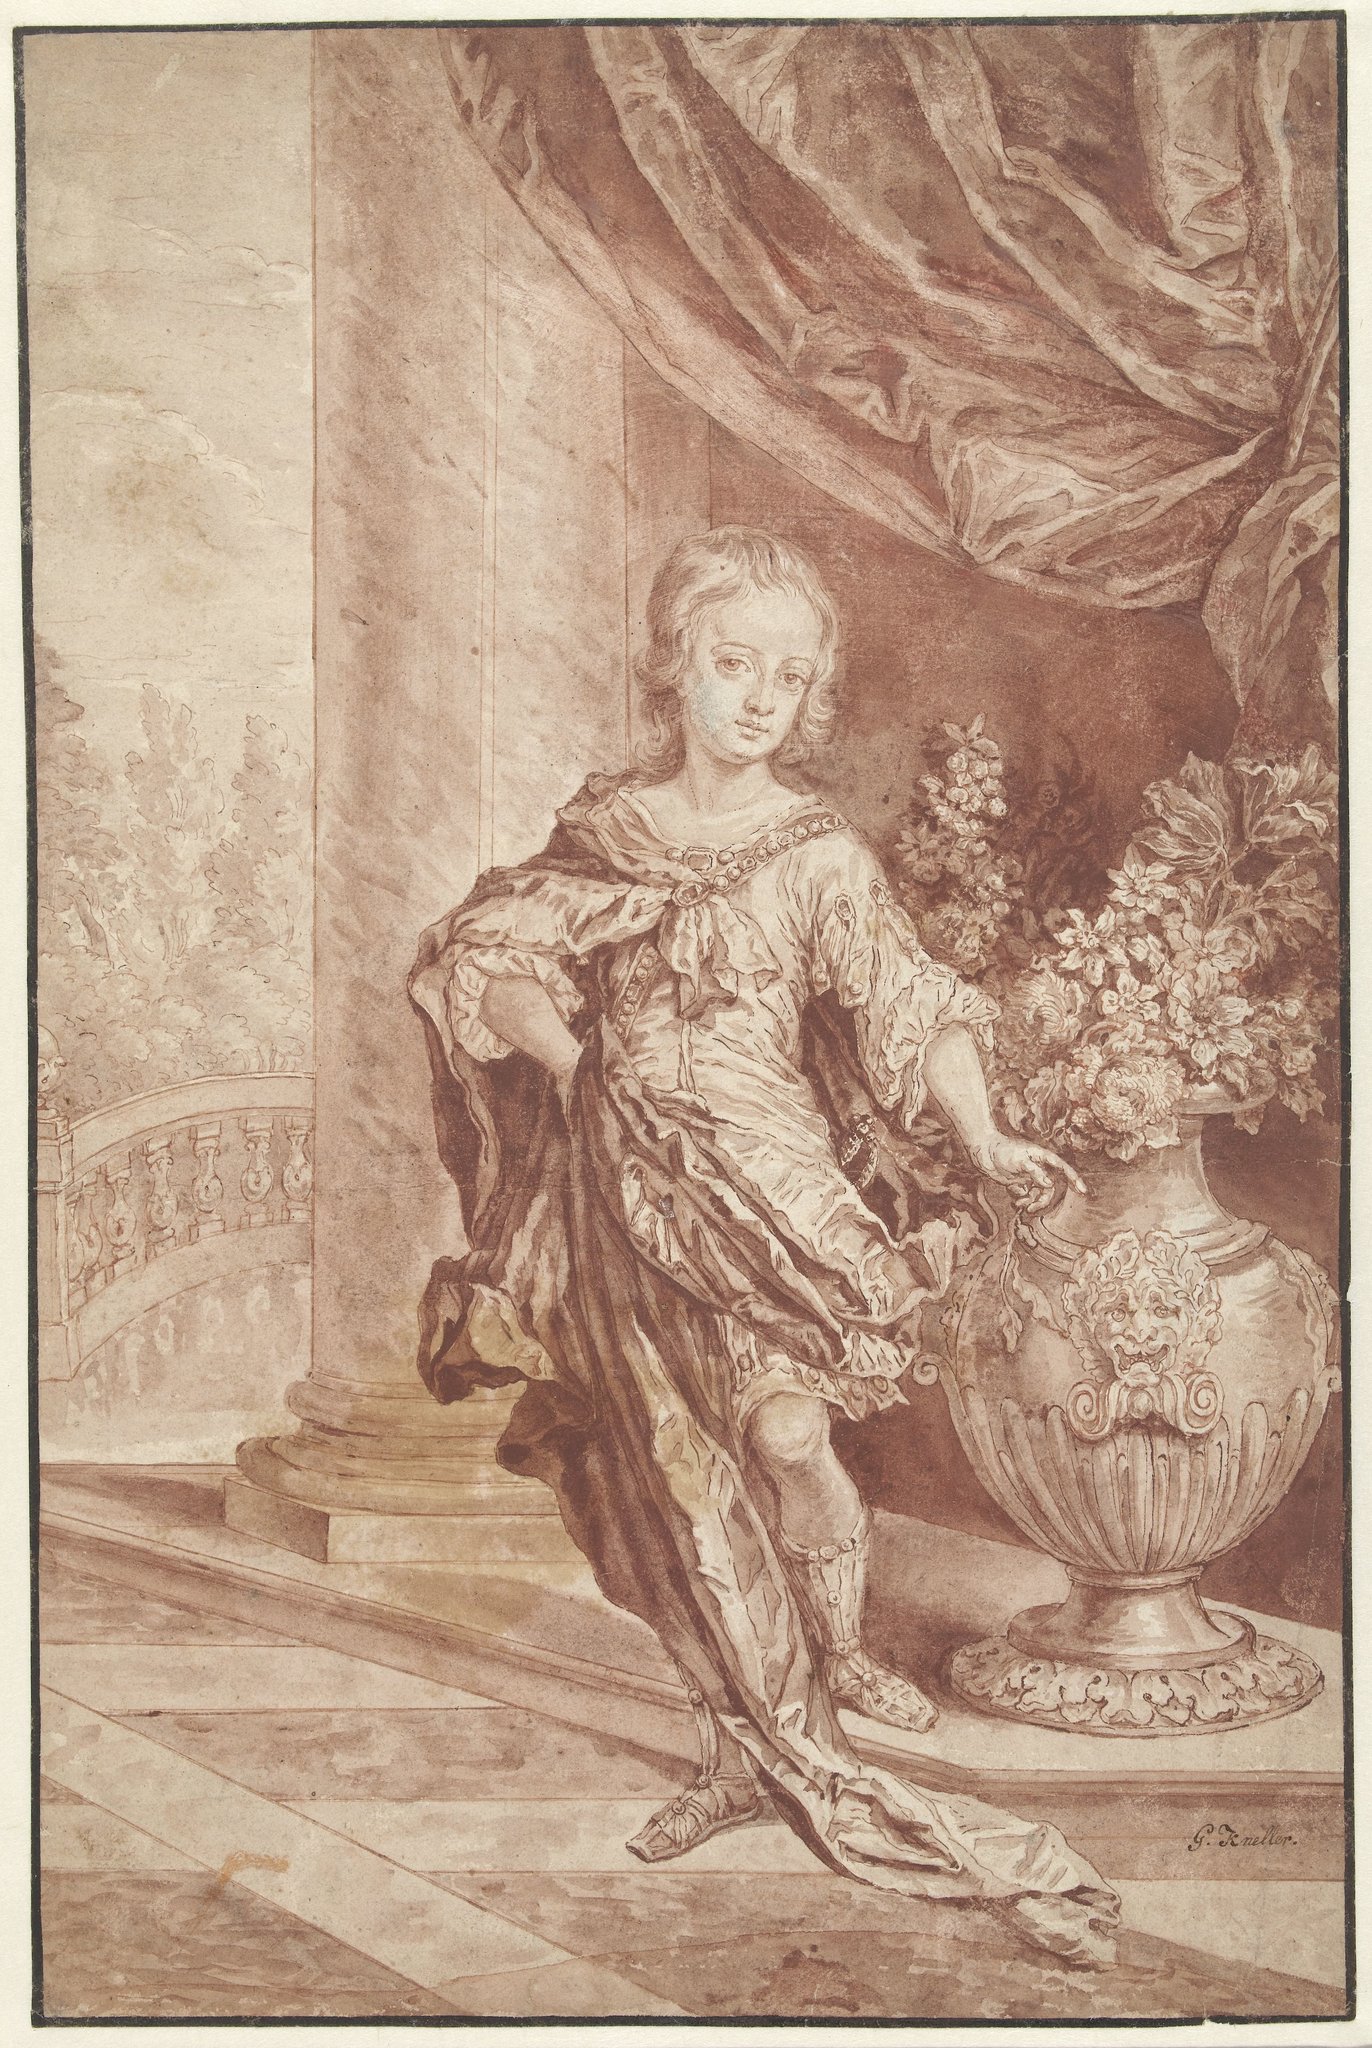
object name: drawing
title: Portrait of an Unknown Young Man in an Imagined Roman Costume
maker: gottfried kneller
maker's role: draughtsman, painter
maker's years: 1646-1723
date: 1656-1723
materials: chalk, ink, paper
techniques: brush, pen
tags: boy (child between toddler and youth), youth, adolescent, historical persons not known by name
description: Jongensportret in Romeins fantasiekostuum, in de vestibule van een groot paleis naast een grote tuinvaas met bloemen staande.